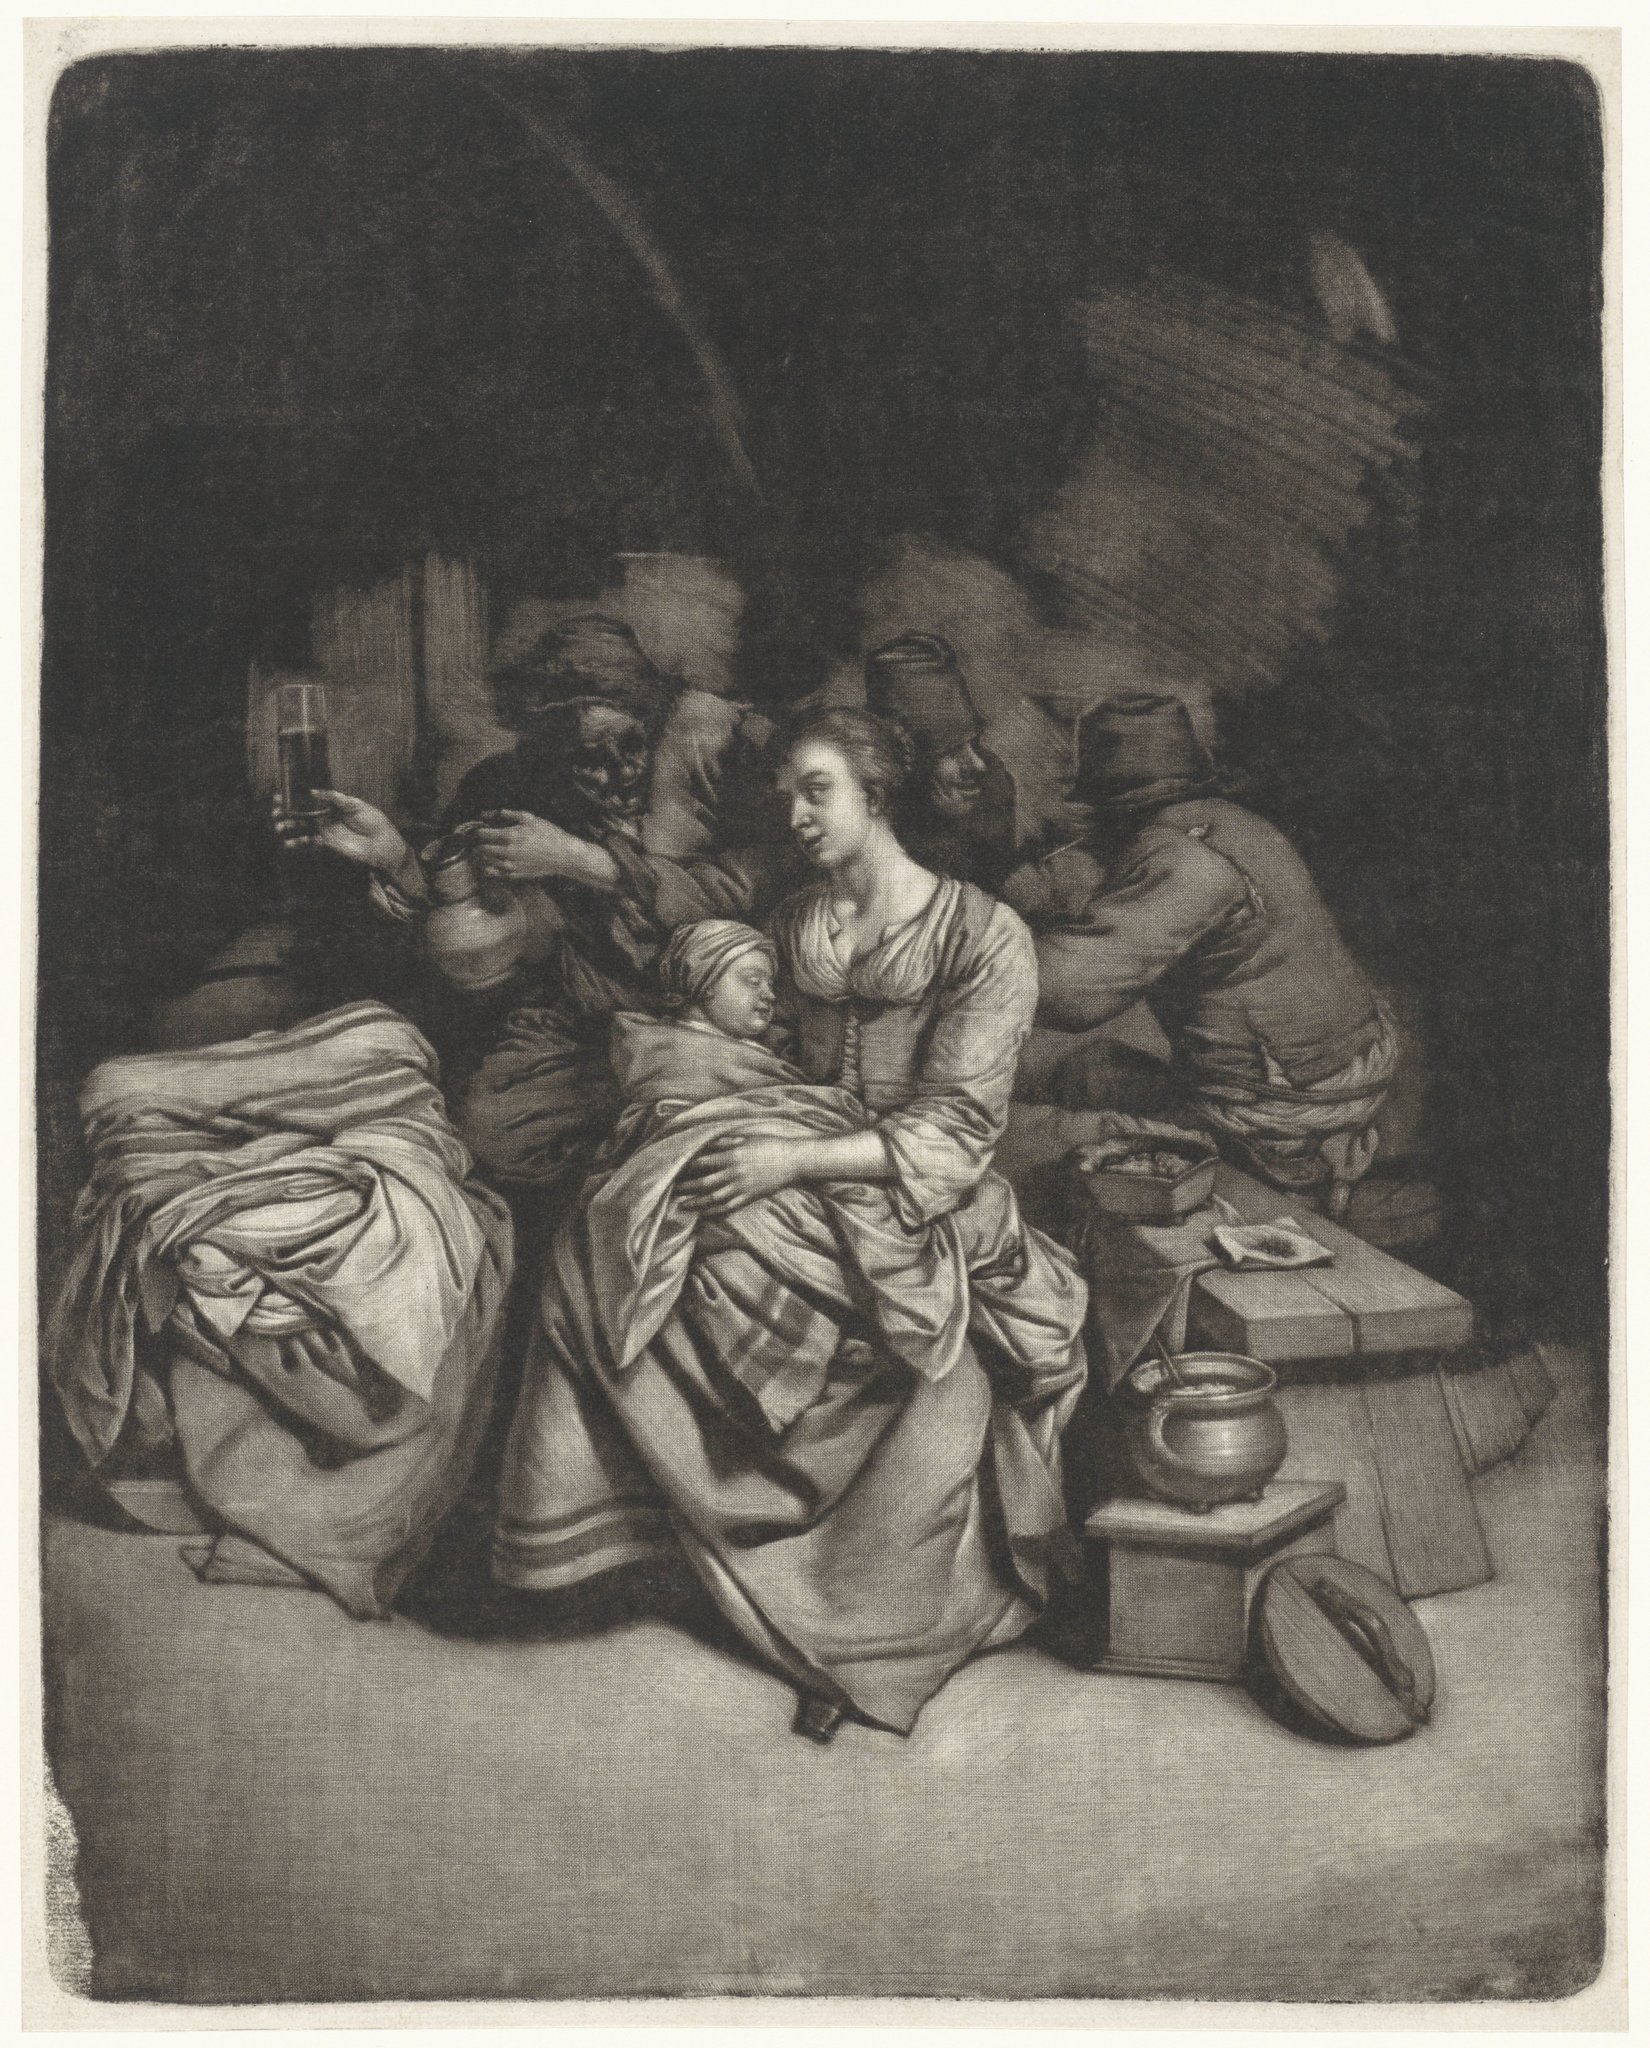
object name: print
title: Vrouw met een slapend kind in een herberg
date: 1658-1677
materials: paper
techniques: mezzotint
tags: inn, coffee-house, public house, etc., pipe ~ tobacco, mother and baby or young child, watching a sleeping child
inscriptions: collector's mark: Lugt 2228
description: In een herberg zit een een vrouw met een slapend kind op haar schoot tussen de pijprokende en drinkende mannen. Naast haar staat een pot met eten op een stoofje.